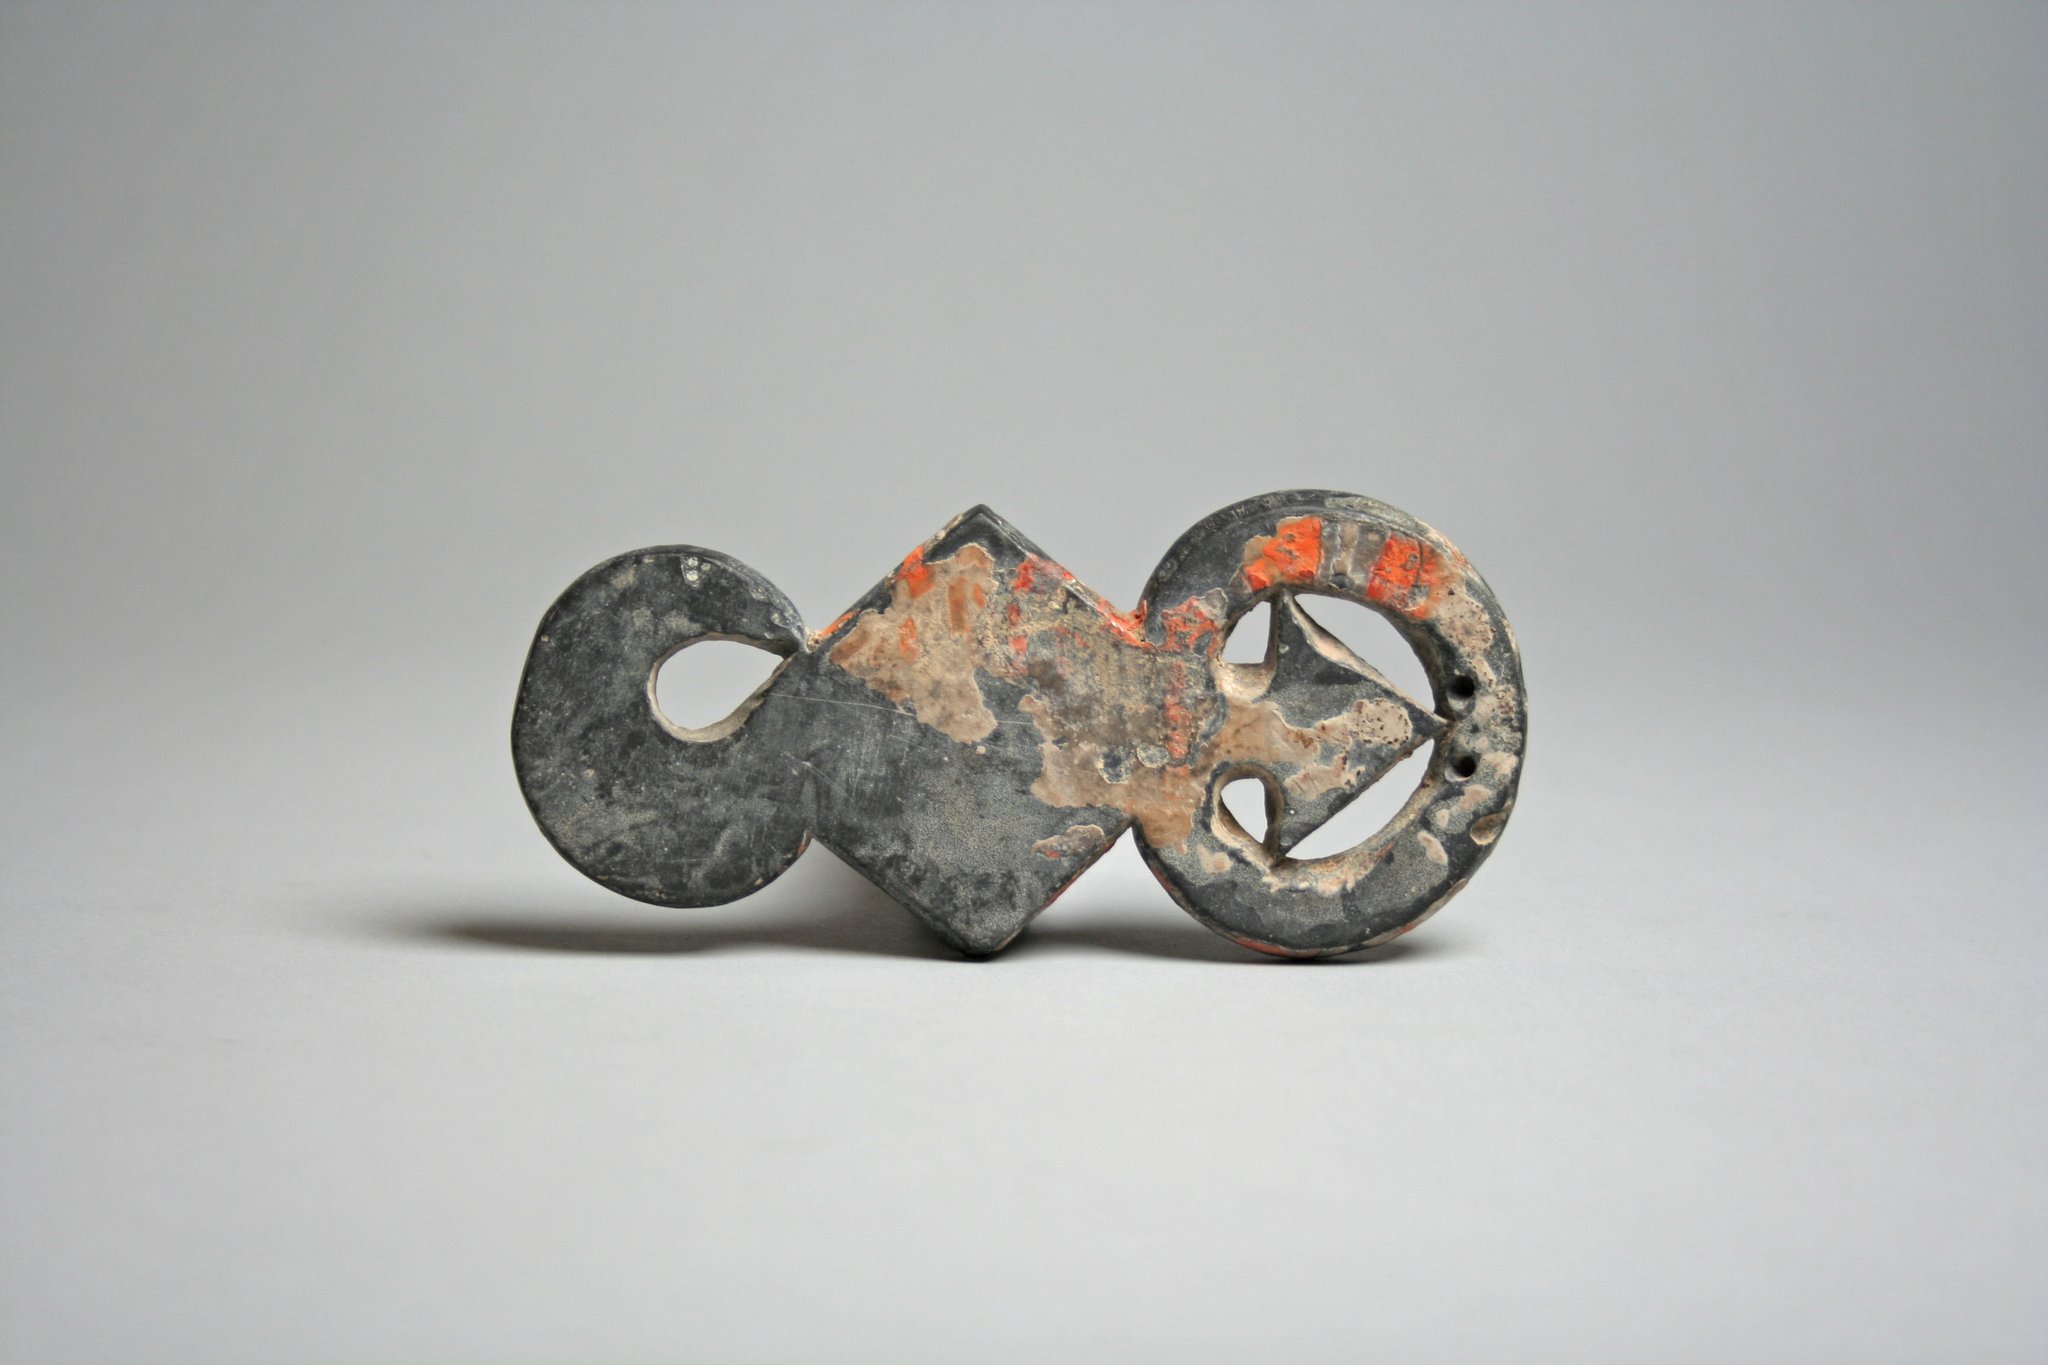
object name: ornament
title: Slate Scorpion (?) Ornament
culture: mezcala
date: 1-800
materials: paint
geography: mexico